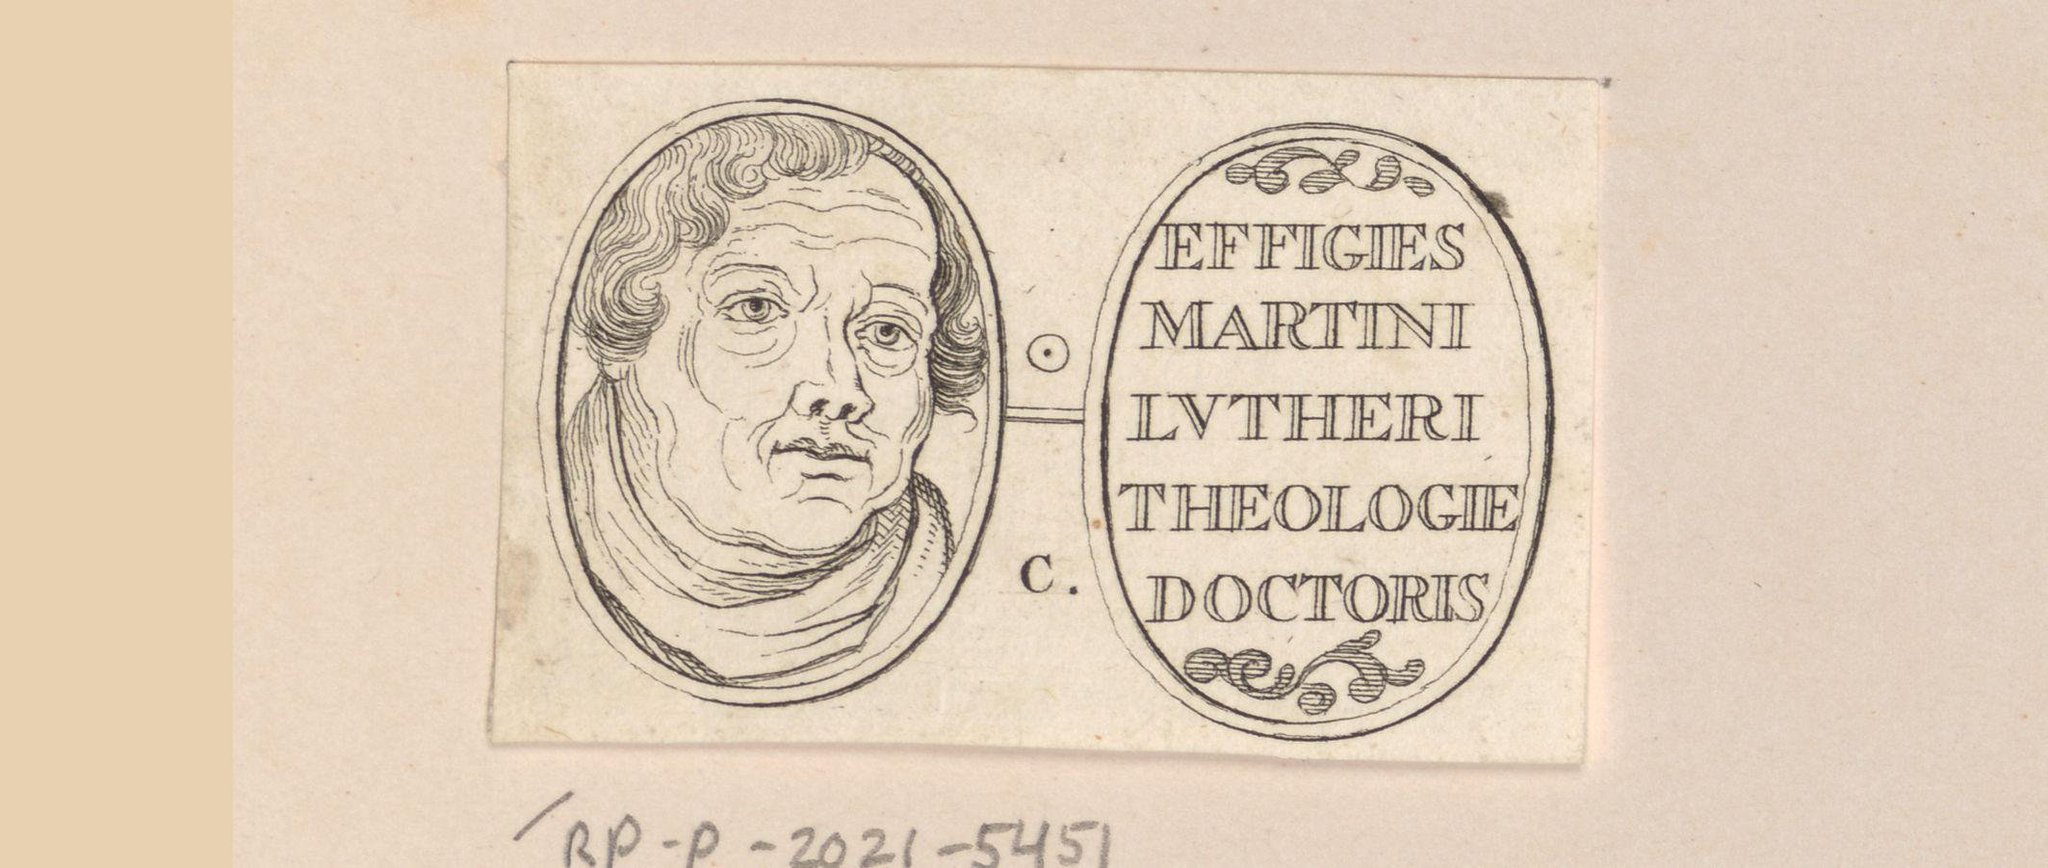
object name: print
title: Voor- en achterzijde van een penning met het portret van Martin Luther en tekst in het Latijn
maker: Anonymous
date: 1728-1734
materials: paper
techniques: etching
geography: northern netherlands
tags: priest, martin luther, historical persons, medal (considered as a piece of sculpture, regardless of its specific function)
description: Prent met tekst in boekdruk op verso waarschijnlijk gebruikt in: Seckendorf, Veit-Ludwig von. Uitvoerige en onpartydige historie der reformatie door dr. Martin Luther (...). Delft: Reinier Boitet, 1728, dl. 3, p. 4. En in de druk uit 1730, en mogelijk ook al in 1726. En in: Juncker, Christian. De goude en zilvere eergedagtenis van Dr. M. Luther (...). Den Haag: s.n., 1734. Op de prent het symbool voor het materiaal goud. De letter C. verwijst naar de eigenaar van de penning.